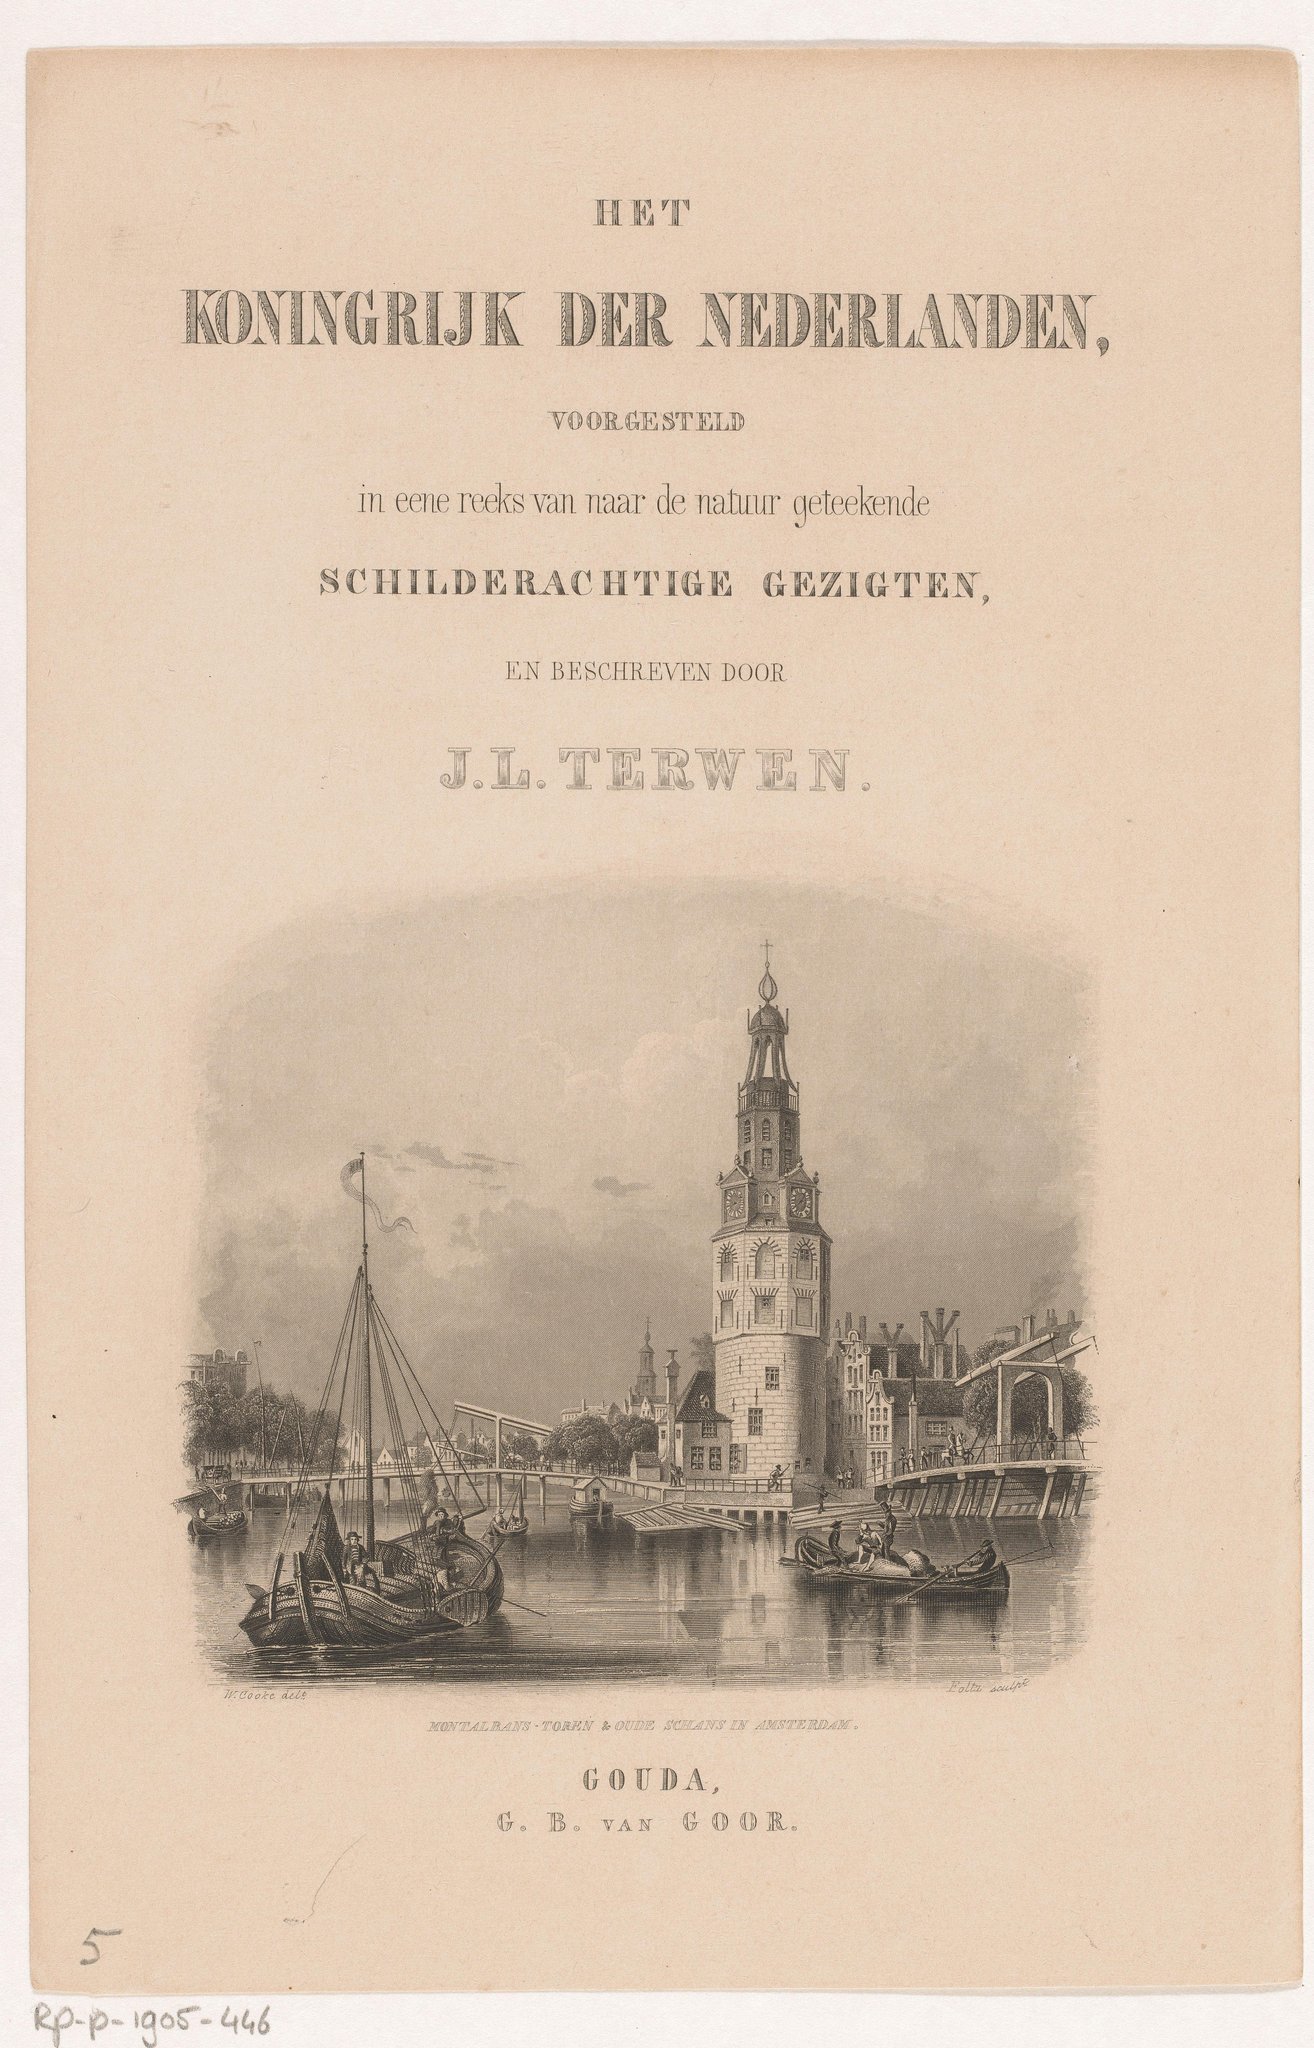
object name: print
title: Titelpagina voor: Johannes Leonardus Terwen, Het Koningrijk der Nederlanden voorgesteld in eene reeks van naar de natuur geteekende schilderachtige gezigten, 1858-1862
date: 1858-1862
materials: paper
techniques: engraving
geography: gouda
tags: tower, clock tower ~ monumental adornment, city-view in general; 'veduta', ships (in general), bridge in city across river, canal, etc.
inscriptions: collector's mark: Lugt 2228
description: Titelpagina gebruikt voor: Terwen, J.L. Het Koningrijk der Nederlanden voorgesteld in eene reeks van naar de natuur geteekende schilderachtige gezigten. Gouda: Gerrit Benjamin van Goor, 1858-1862.